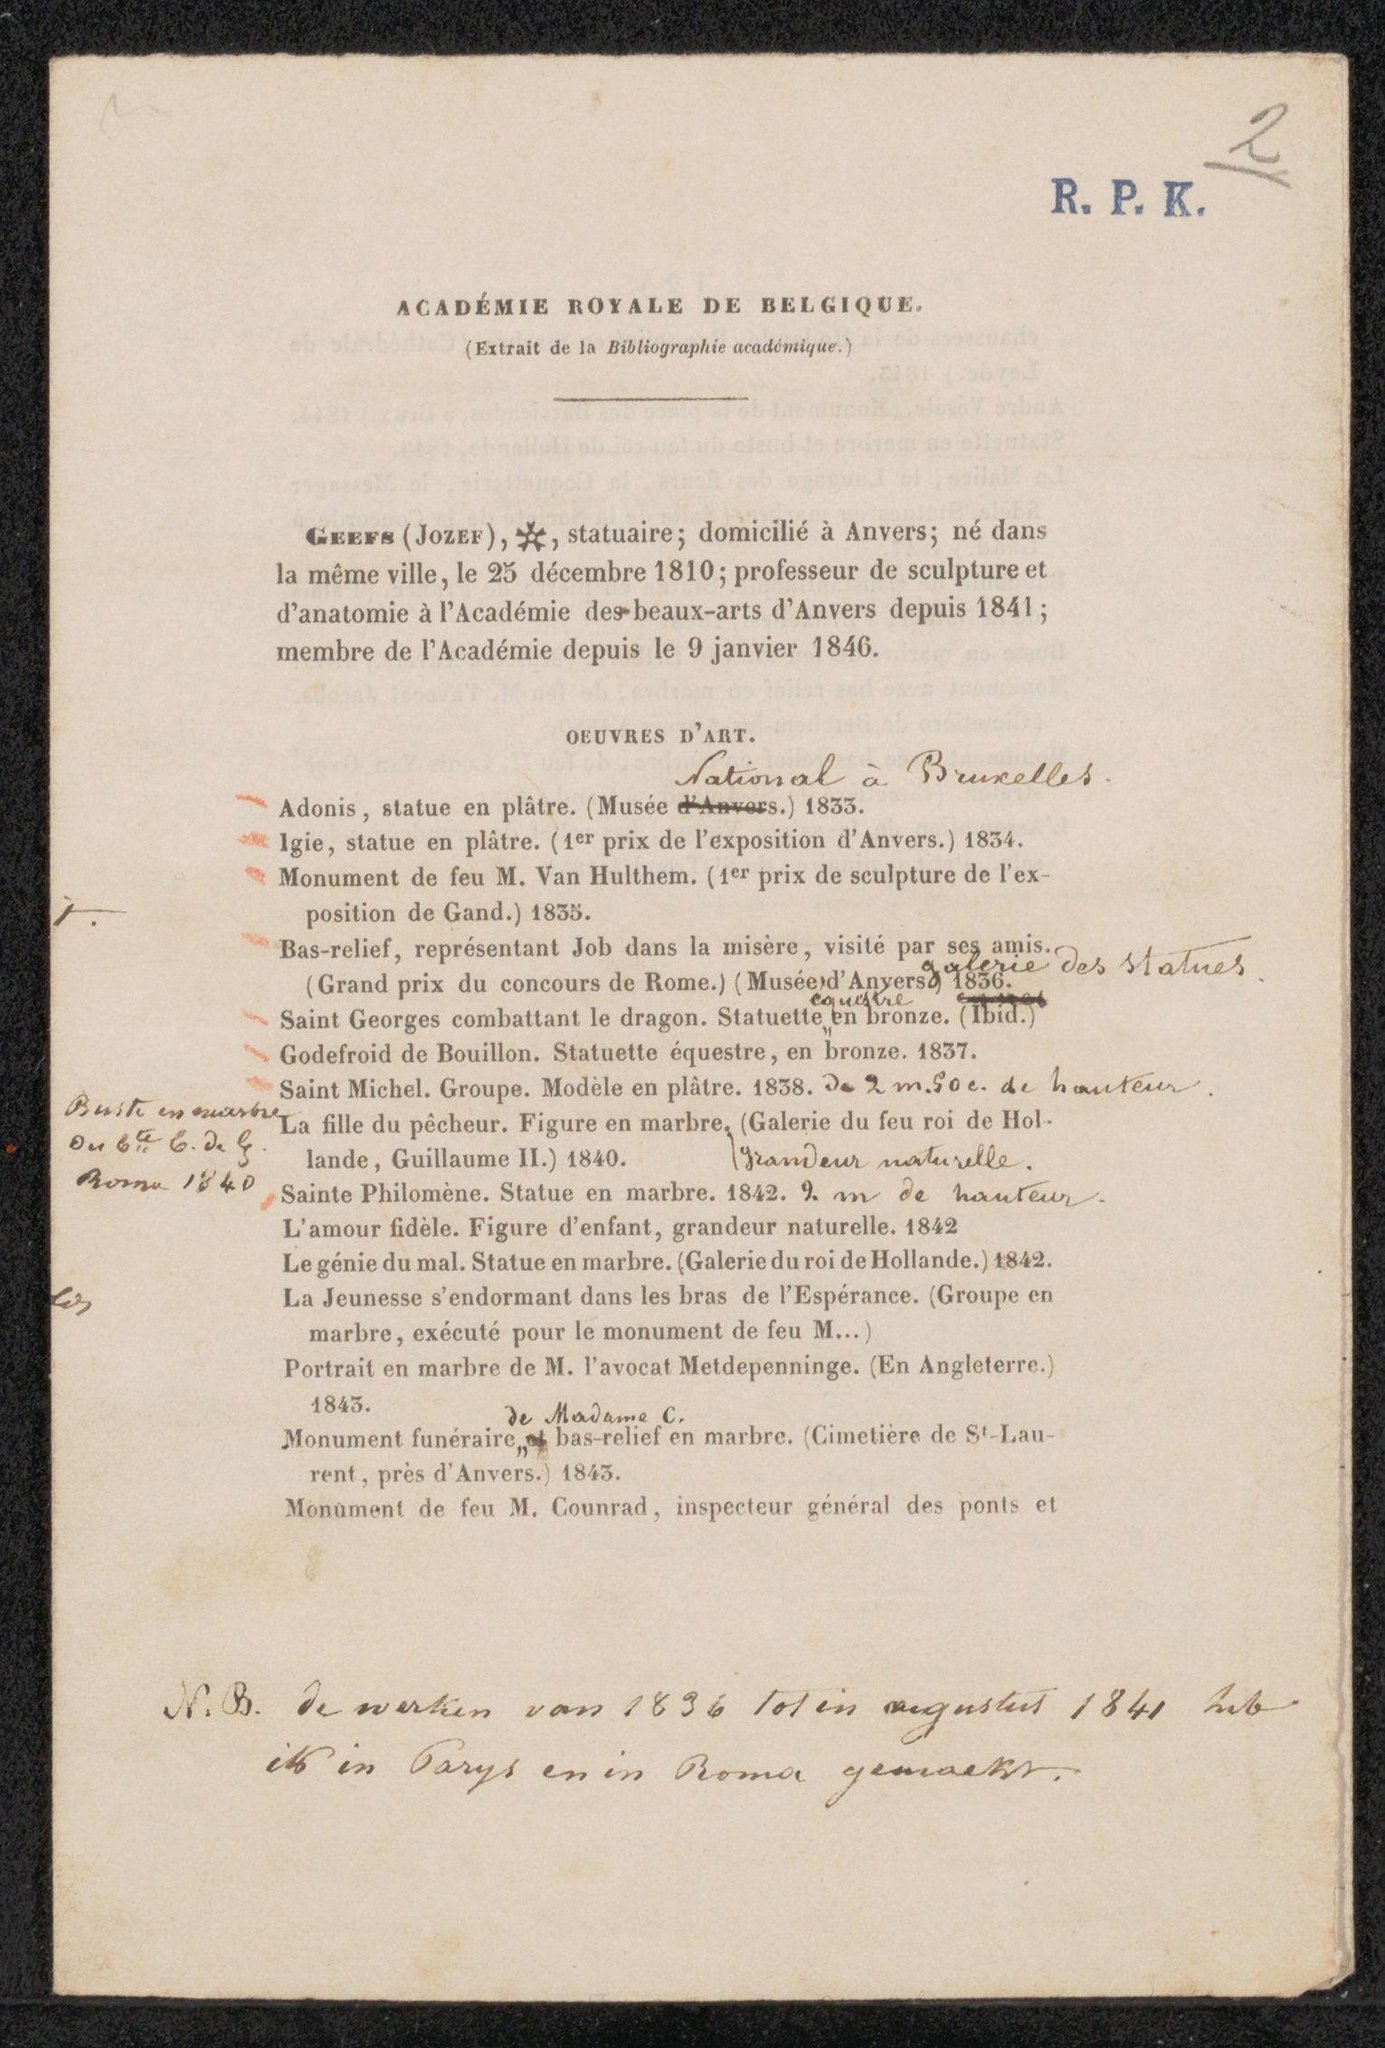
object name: letter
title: Brief aan Christiaan Kramm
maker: jozef geefs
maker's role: sculptor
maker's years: 1808-1885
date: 1857-1885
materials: ink, paper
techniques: pen, printing, writing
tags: utrecht, print maker, draughtsman, christiaan kramm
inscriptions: collector's mark: Lugt 2233